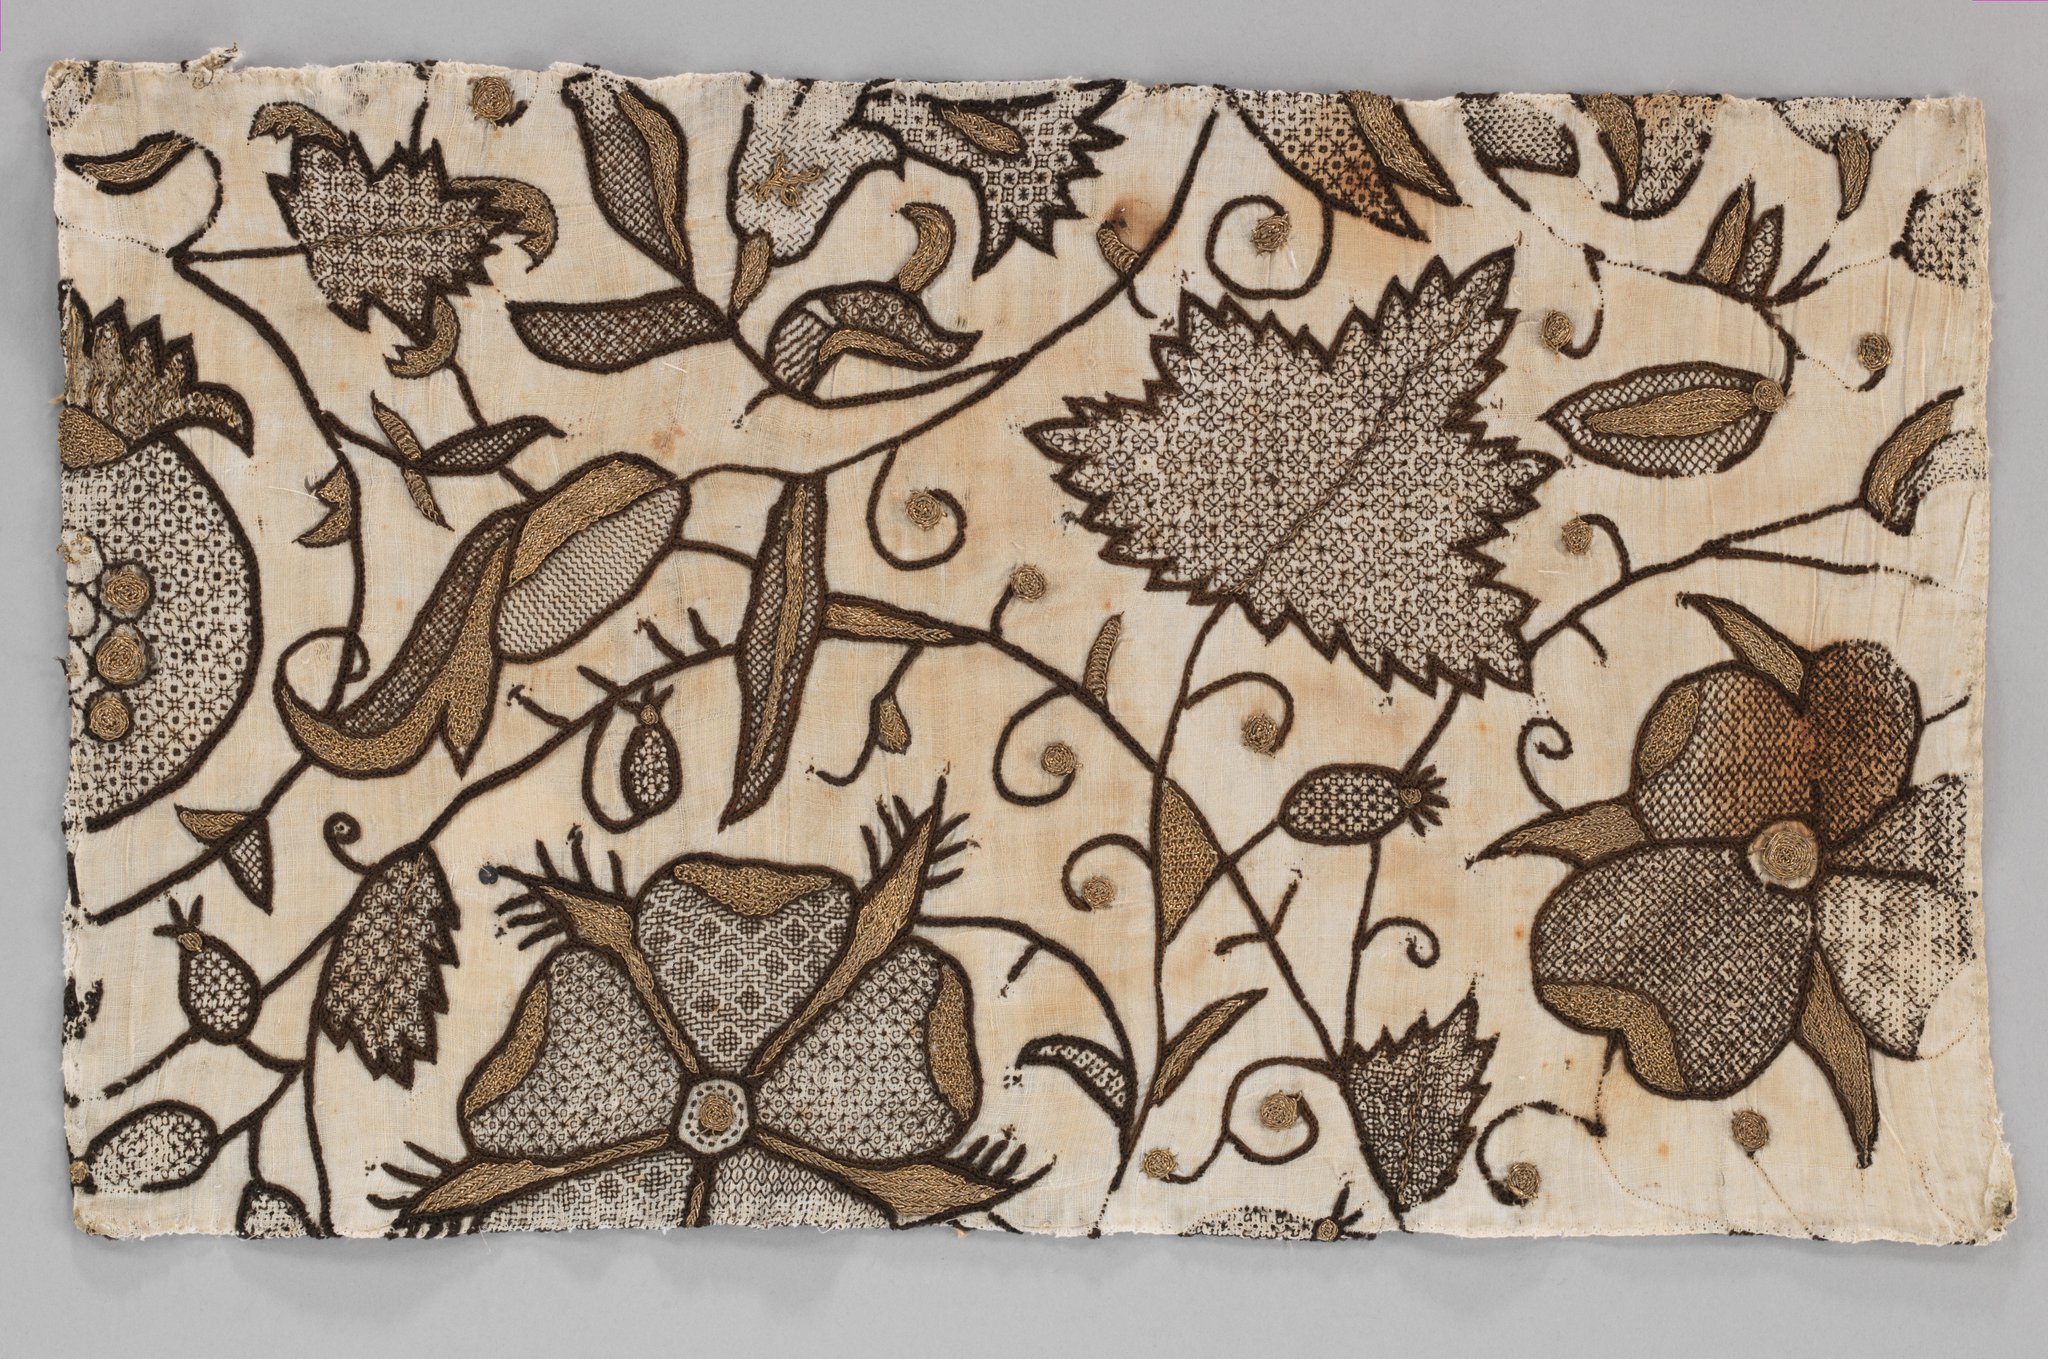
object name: fragment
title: Blackwork Embroidery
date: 1590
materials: gilt silver, linen, metal, silk, thread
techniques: embroidery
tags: flowers